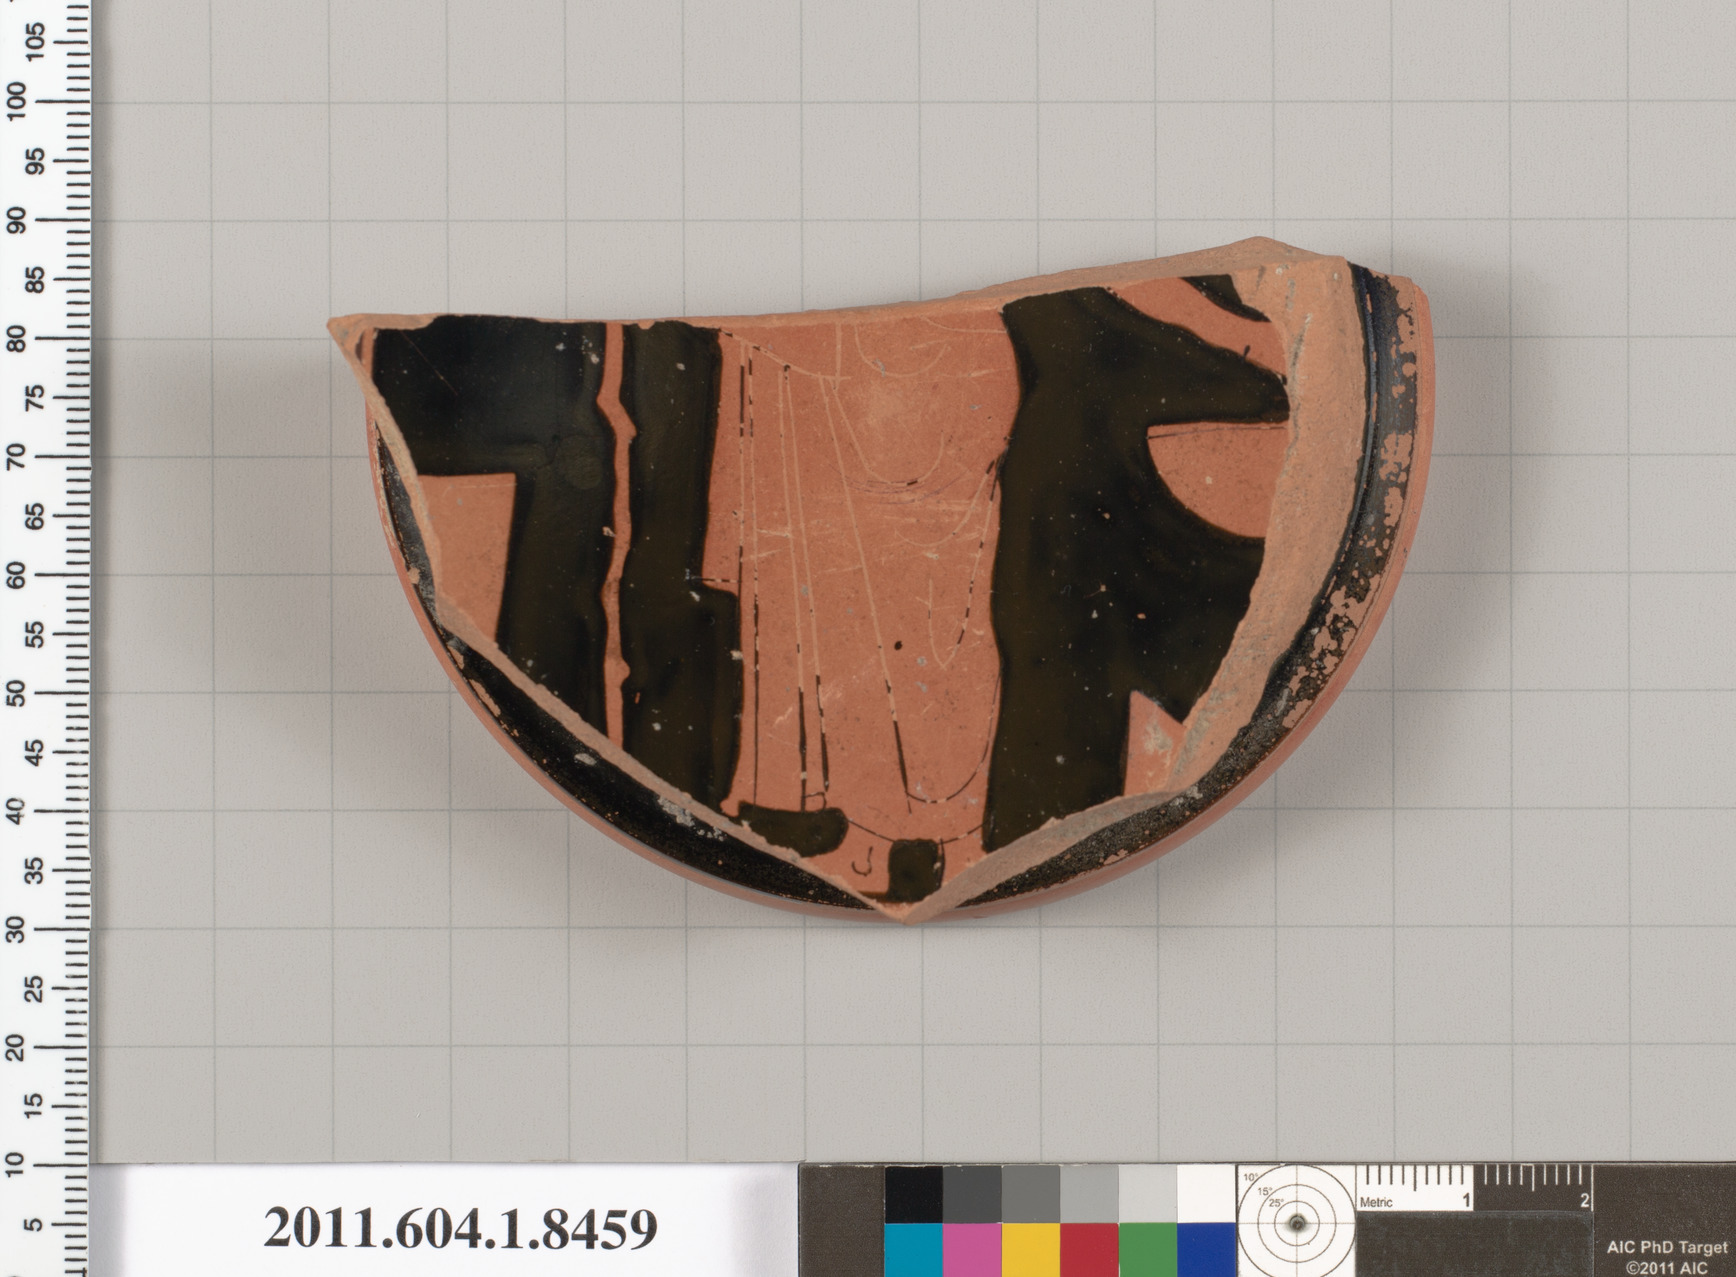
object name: kylix fragment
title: Terracotta fragment of a stemless kylix (drinking cup)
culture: greek, attic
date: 467-435 BCE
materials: terracotta